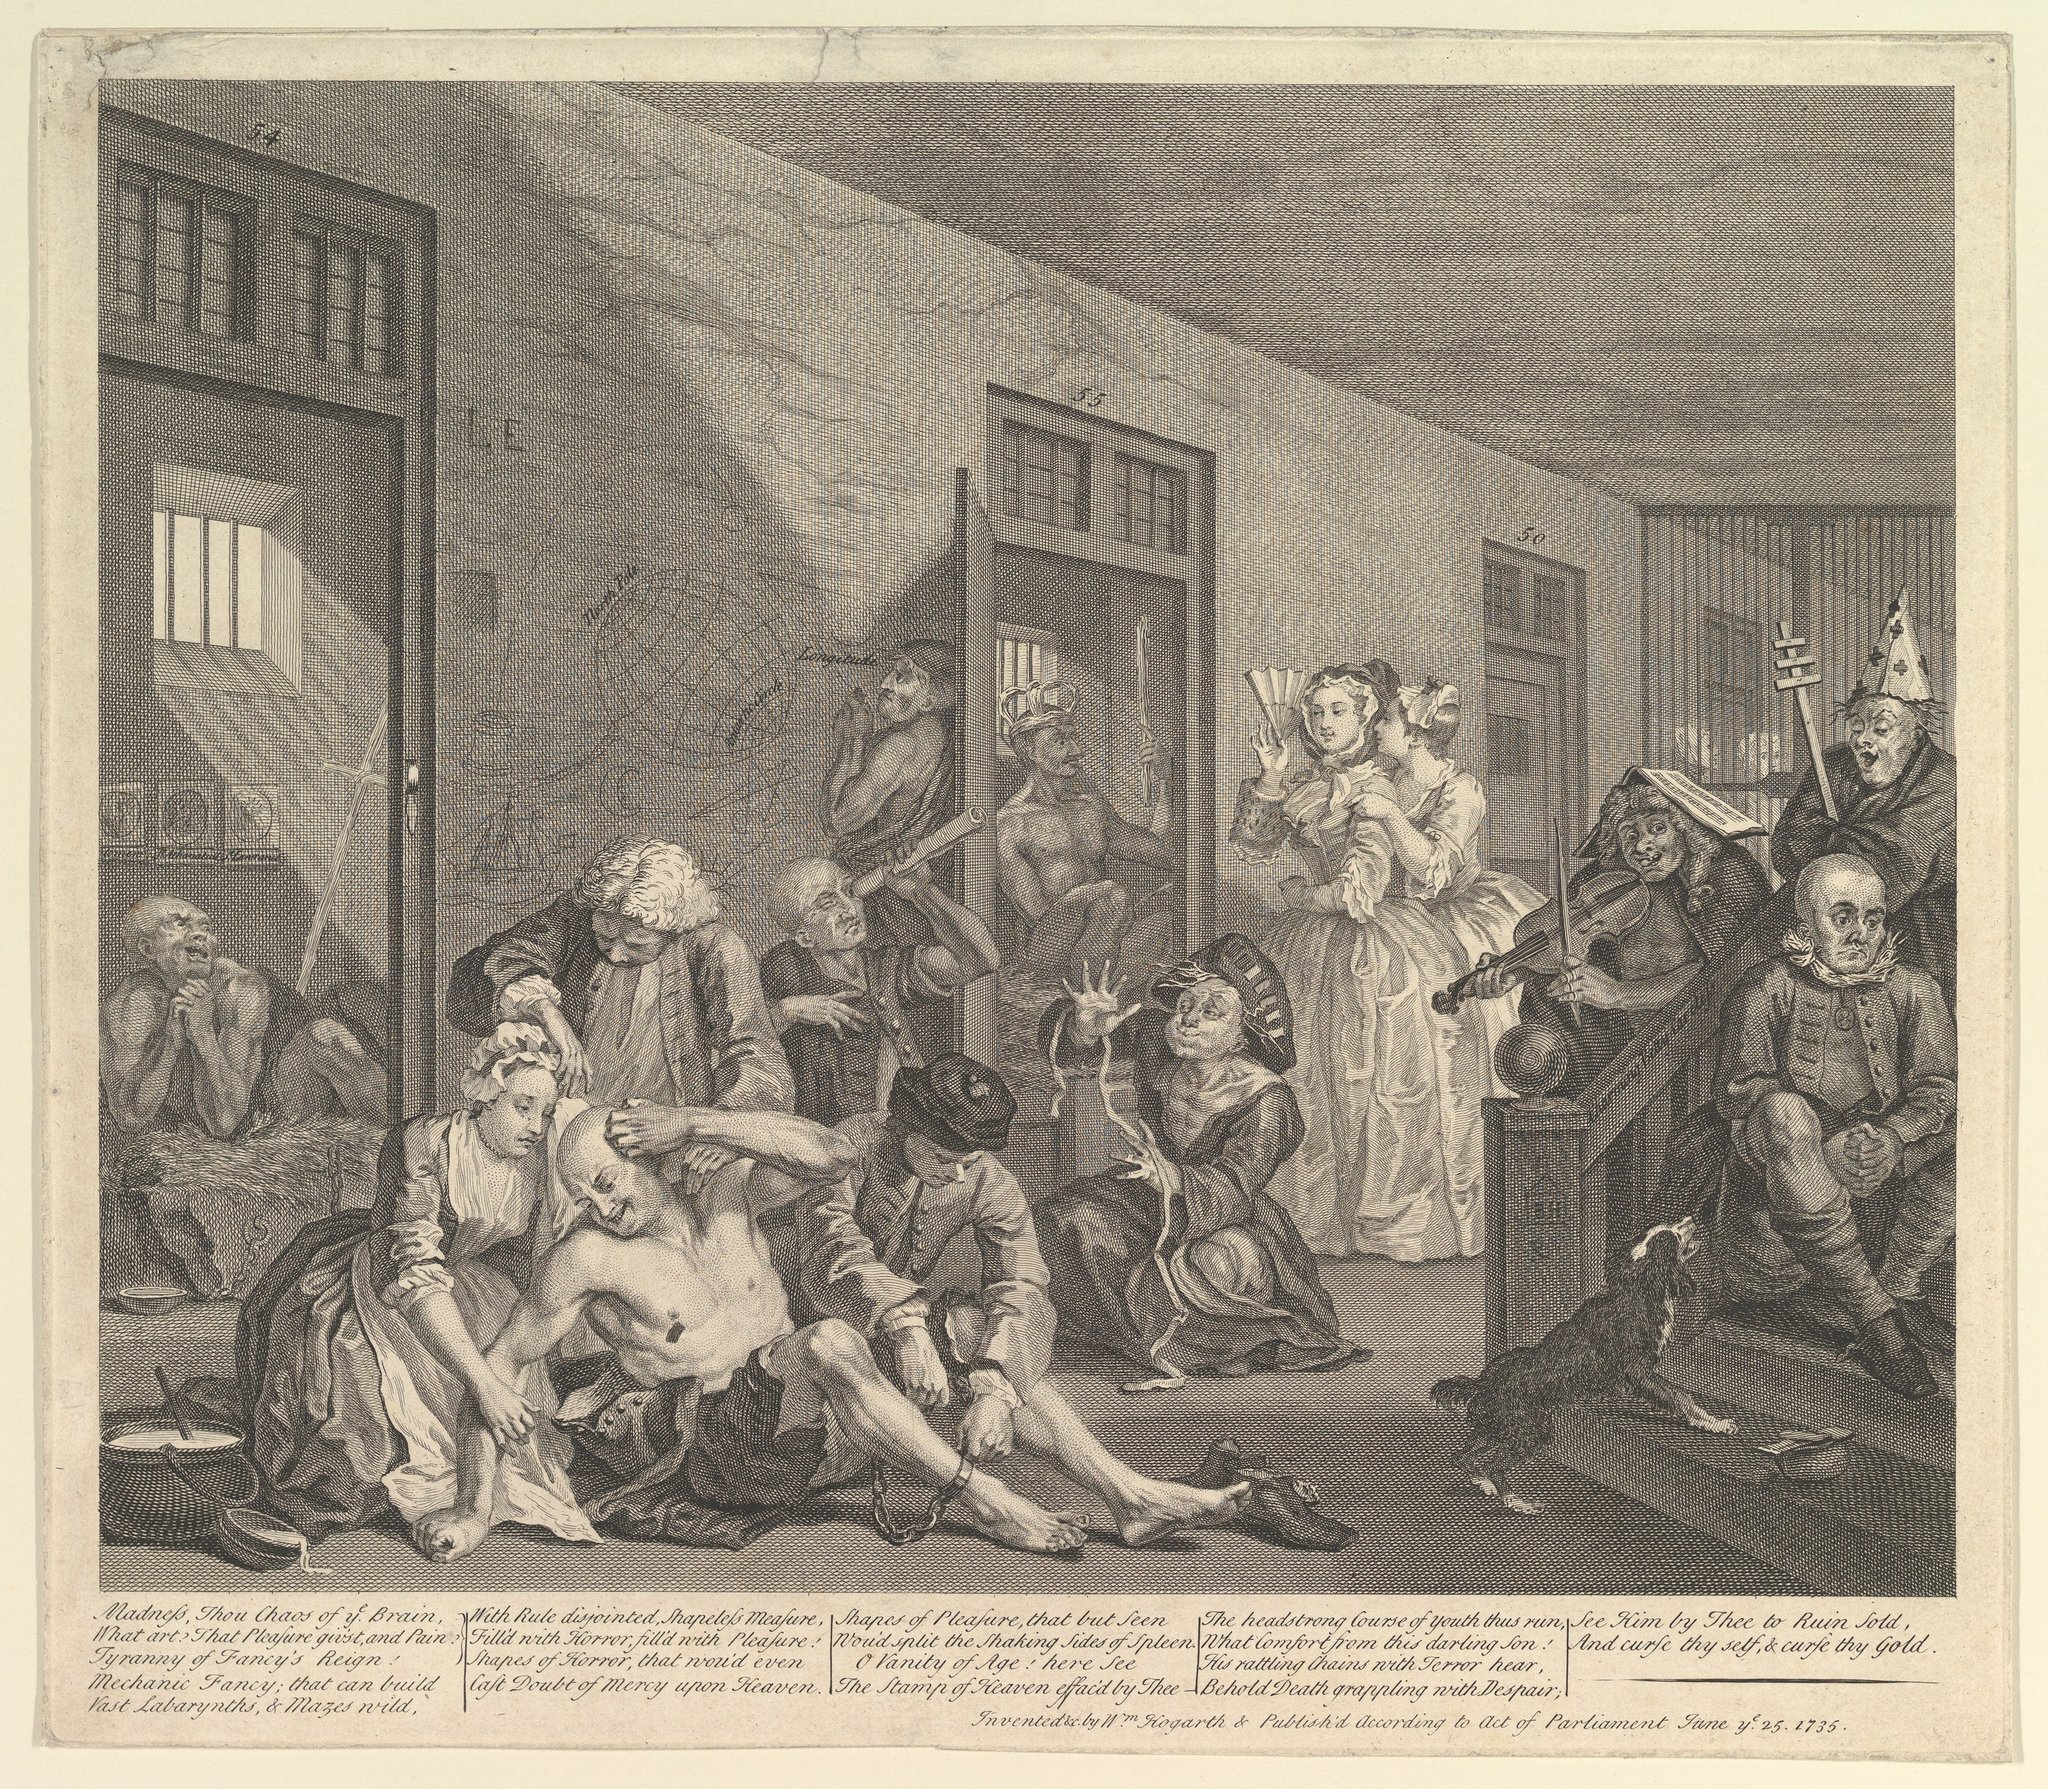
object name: print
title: A Rake's Progress, Plate 8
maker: william hogarth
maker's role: artist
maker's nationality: british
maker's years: 1697-1764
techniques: engraving, etching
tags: men,women,violins,dogs